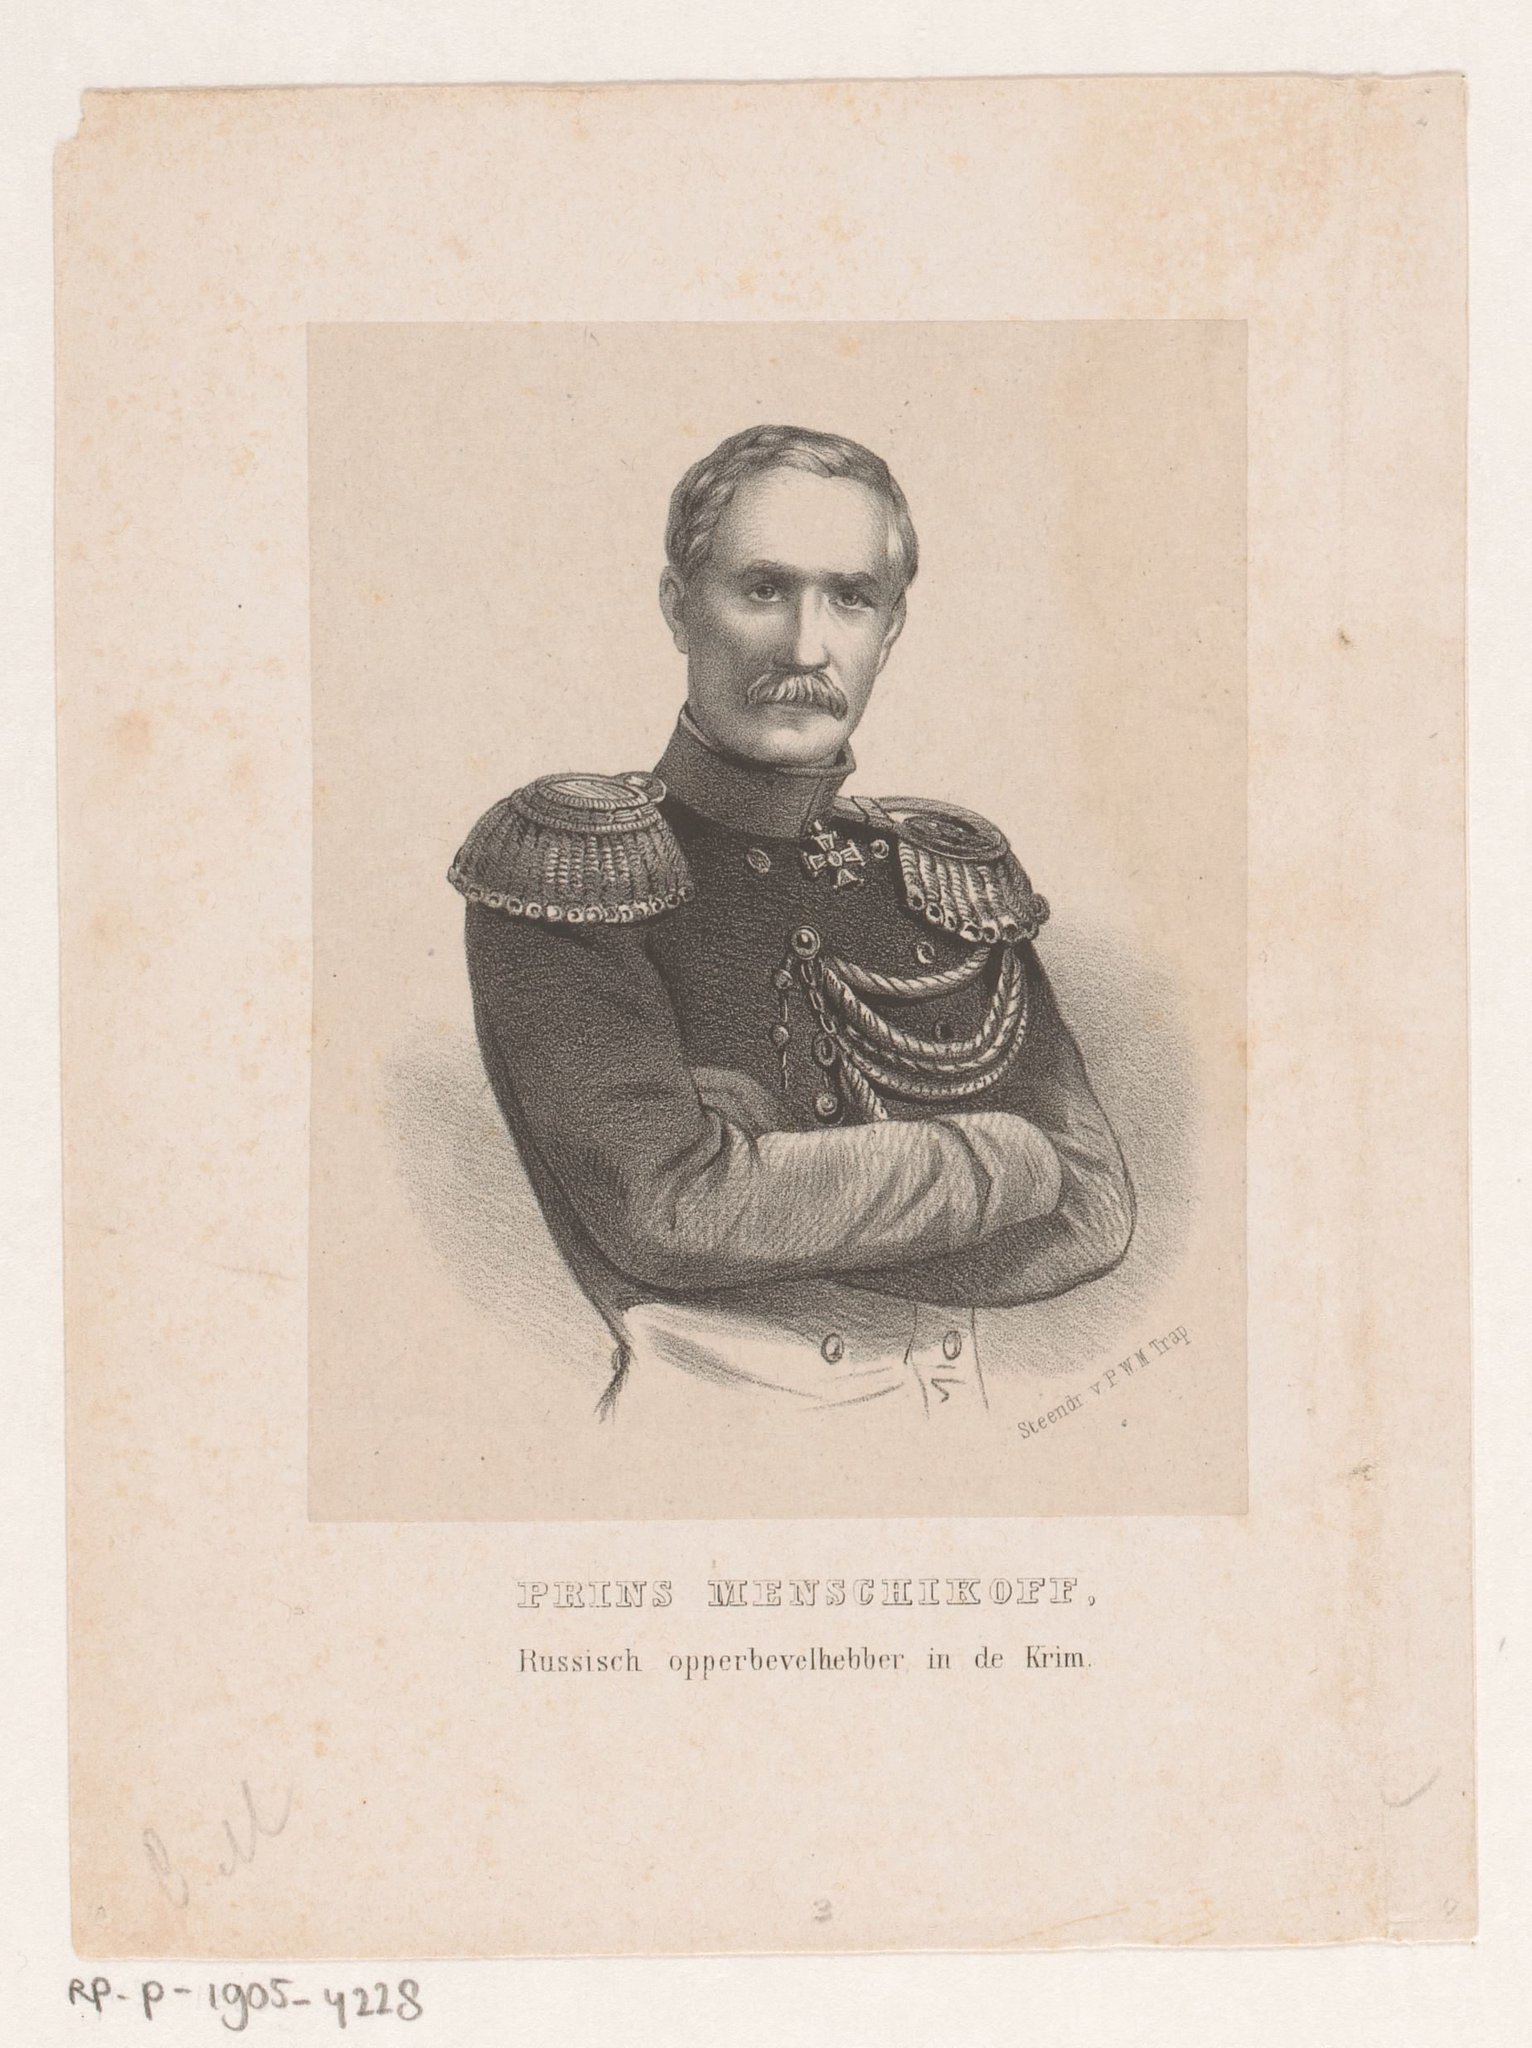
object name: print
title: Portret van Alexander Sergeyevich Menshikov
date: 1853-1876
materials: paper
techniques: lithograph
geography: leiden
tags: politician, knighthood order, historical persons (+ (full) bust portrait), arms crossed over the breast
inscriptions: collector's mark: Lugt 2228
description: De geportretteerde draagt een militair uniform met een ridderorde en een nestel. Hij staat met zijn armen over elkaar. Onder het portret zijn naam en beroep.